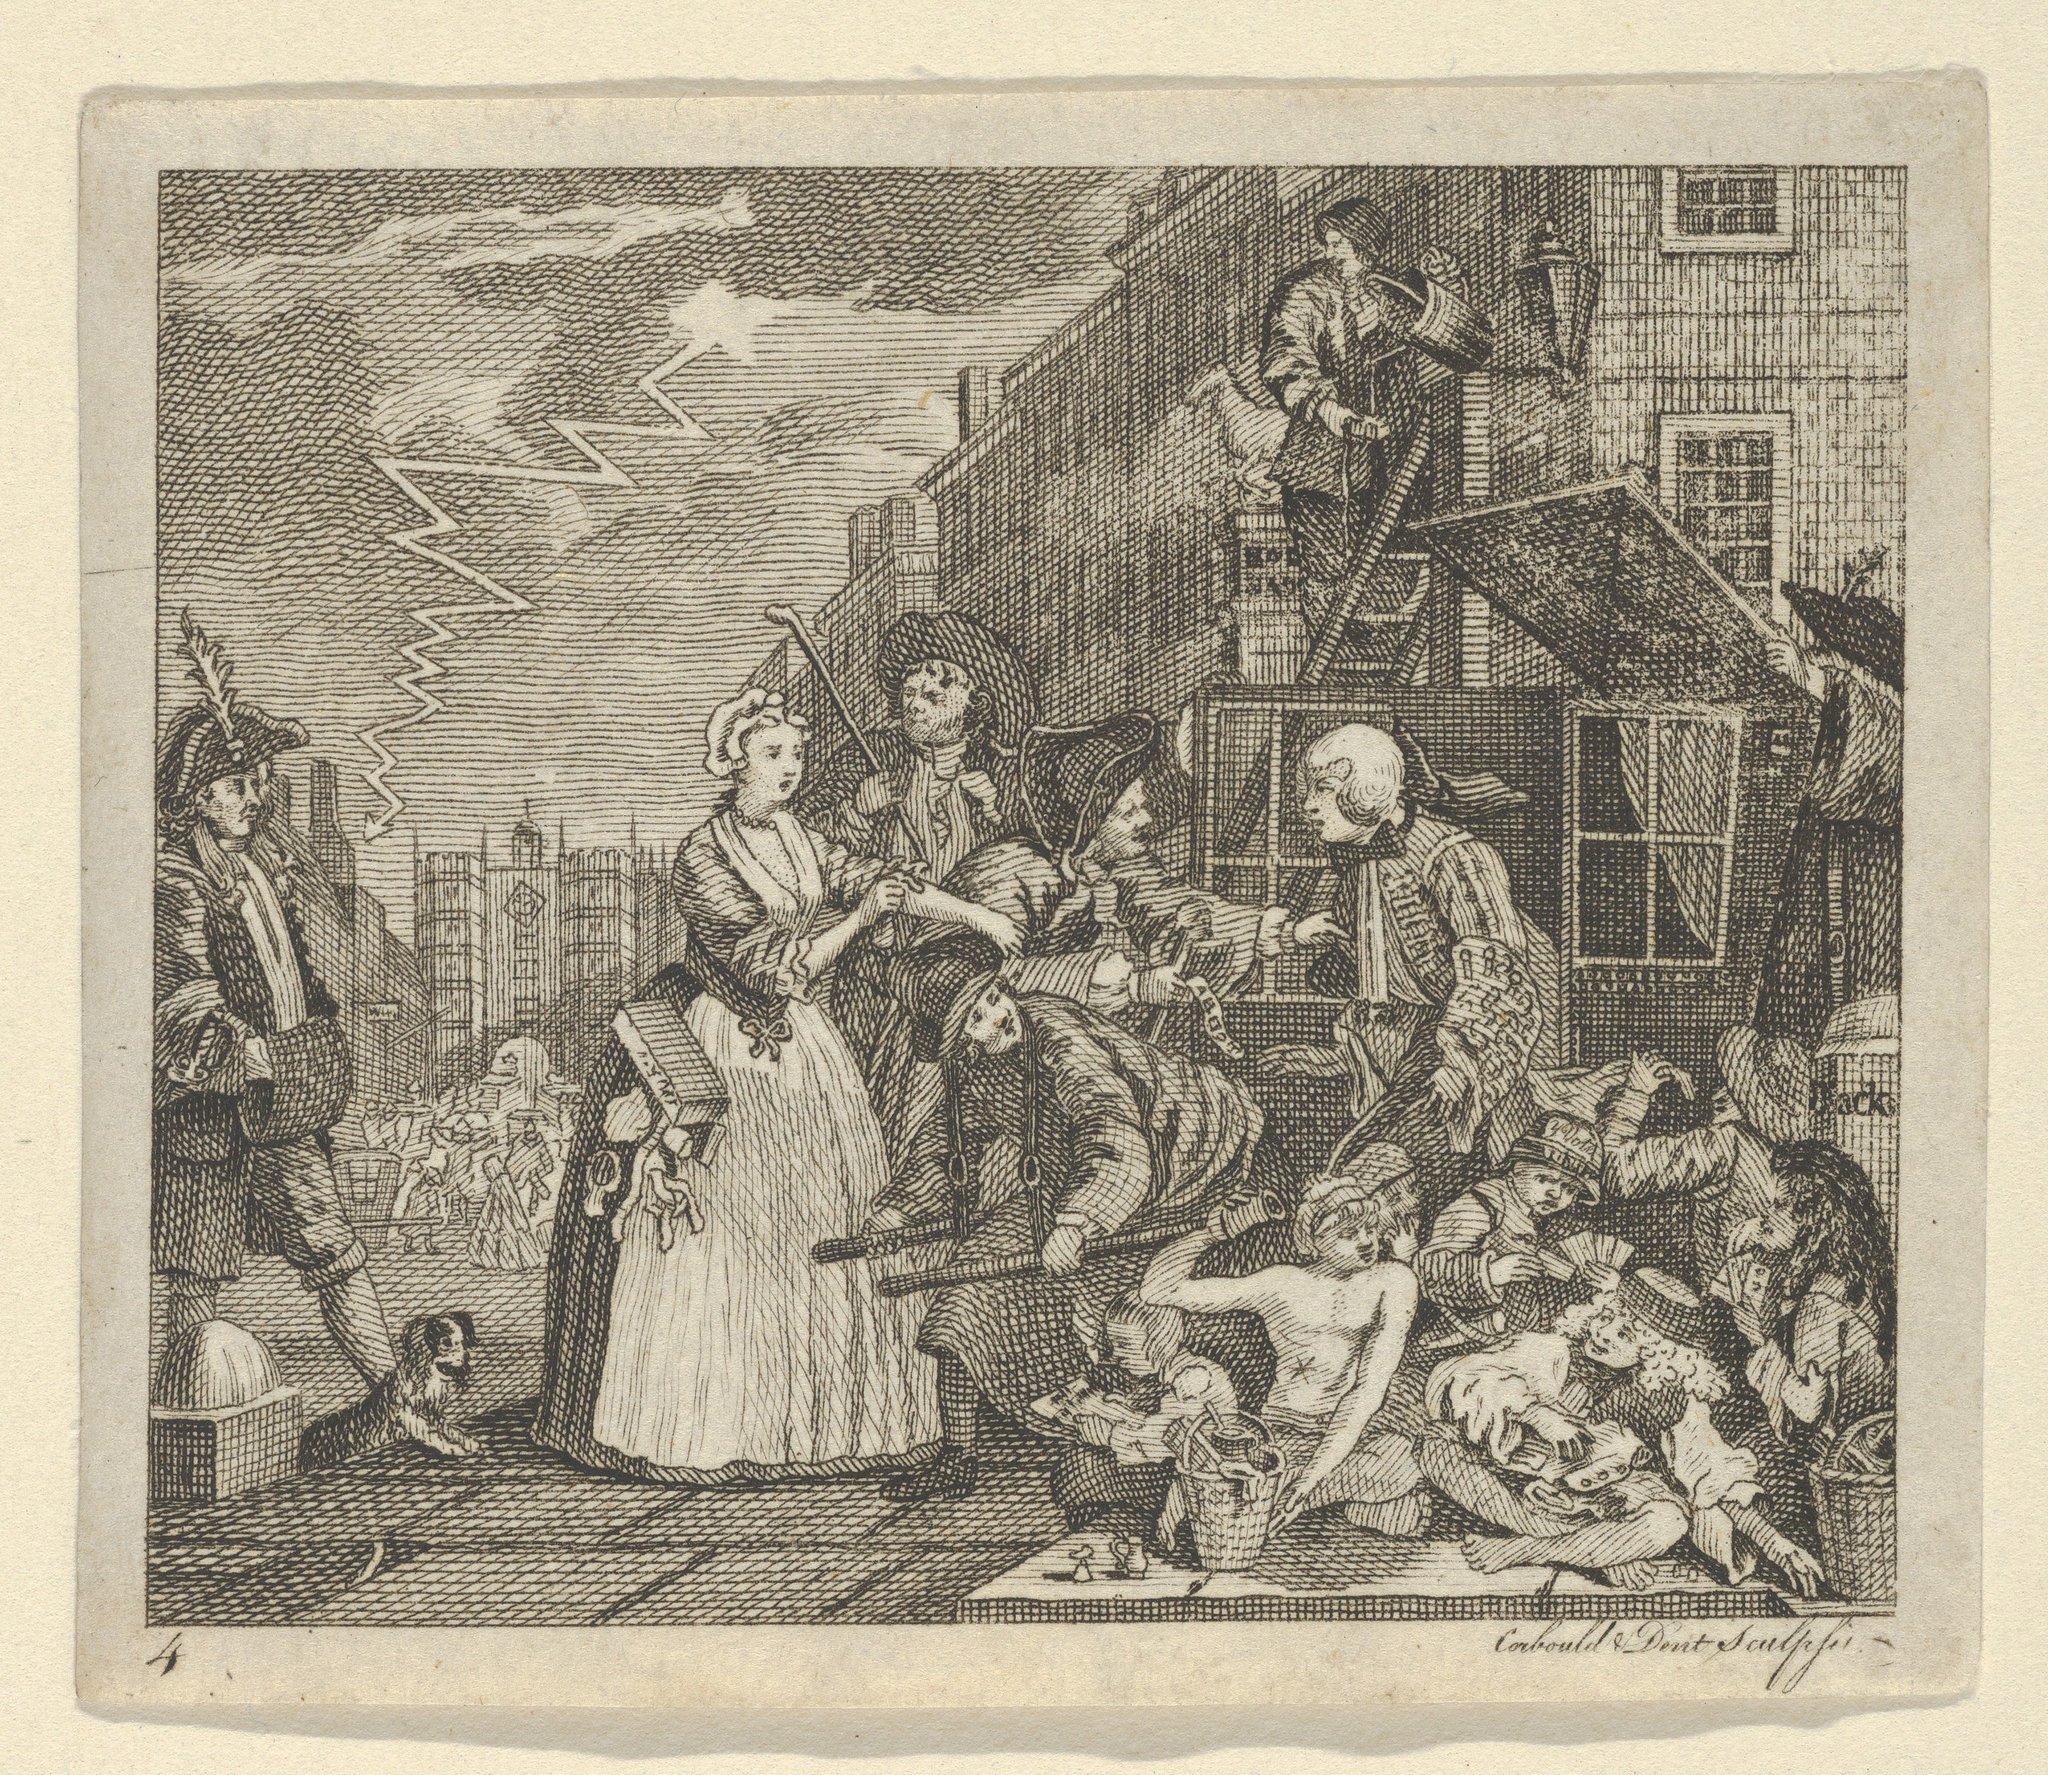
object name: print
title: A Rake's Progress, Plate 4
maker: dent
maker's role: engraver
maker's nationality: british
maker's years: 1800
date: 1800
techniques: engraving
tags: men,women,dogs